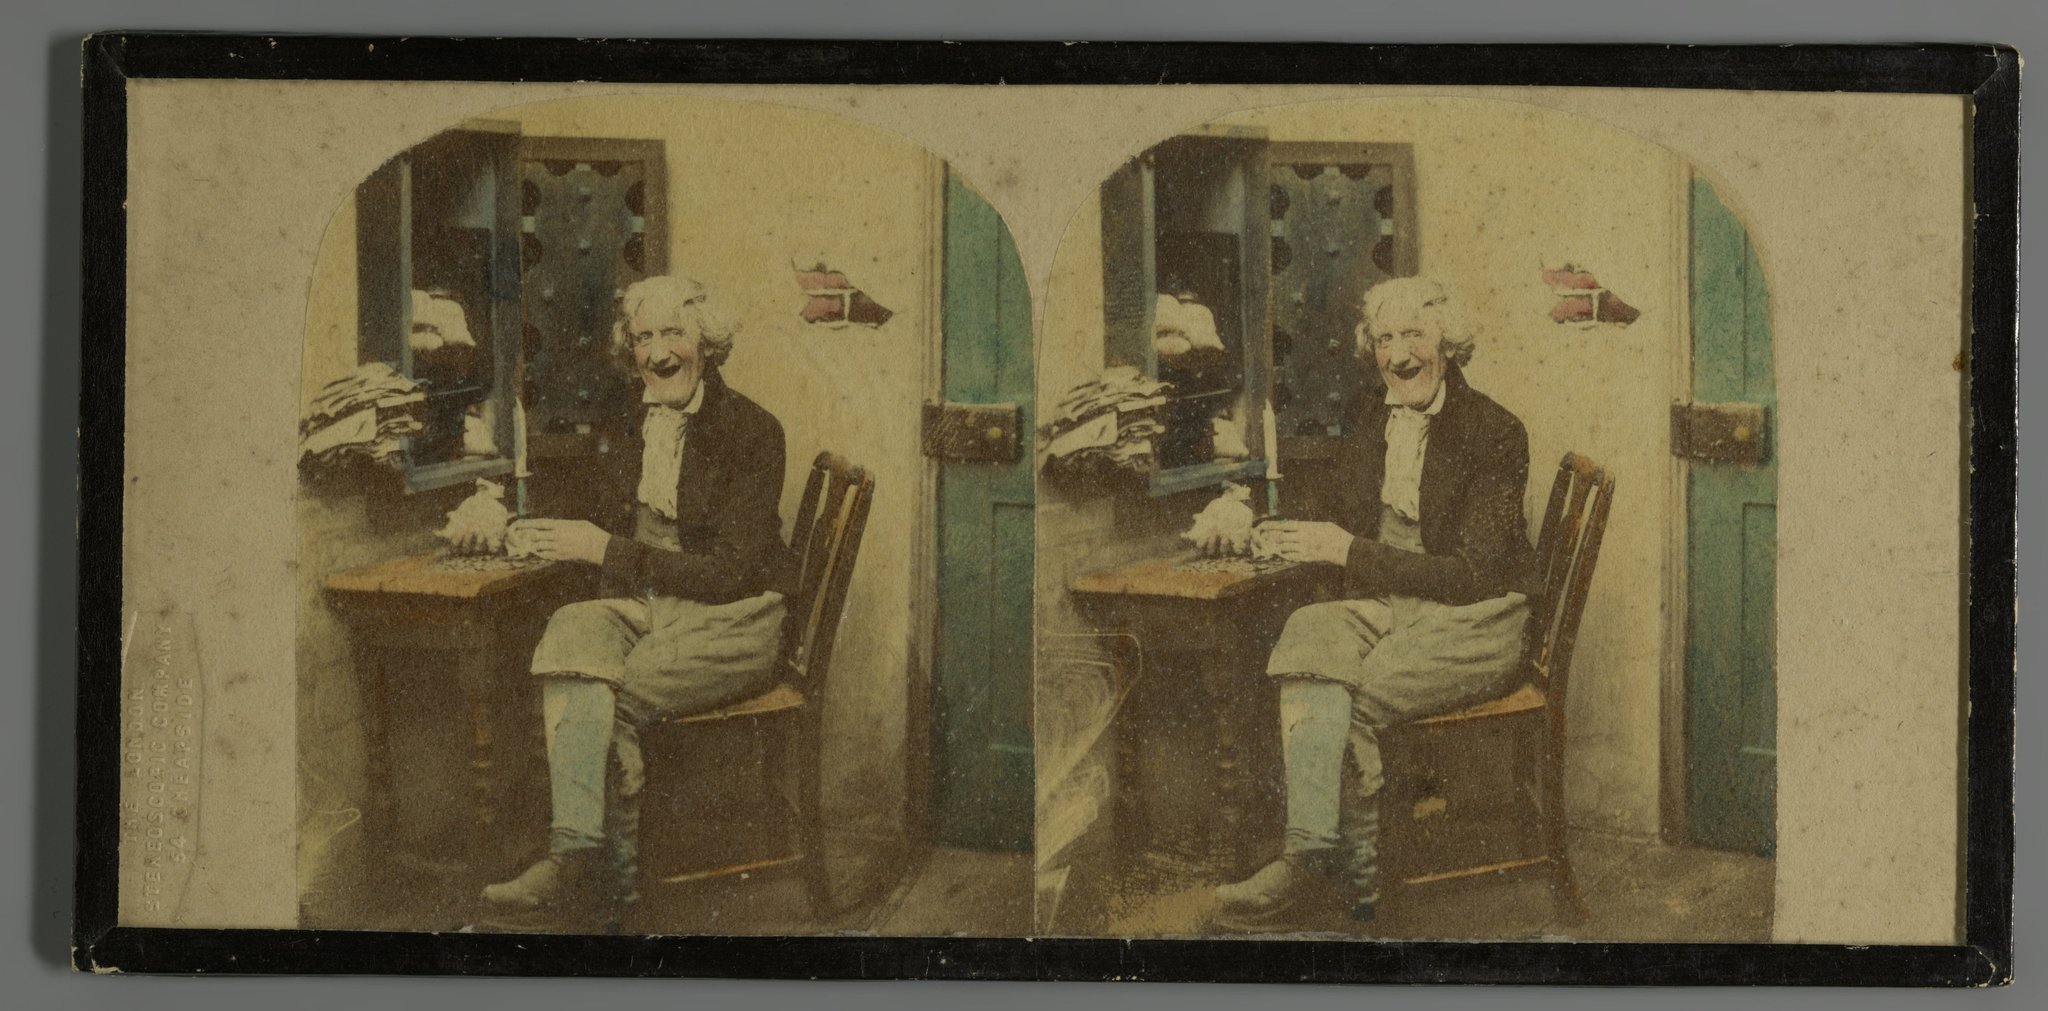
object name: stereoscopic photograph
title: De Vreugd van eenen Gierigaard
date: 1854-1880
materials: cardboard, glass, paper, photographic support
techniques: albumen print, hand coloring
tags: sitting figure, historical persons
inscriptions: inscription: ‘No 149 [...] de vreugd van eenen gierigaard/ door de Lond stereoscop comp’